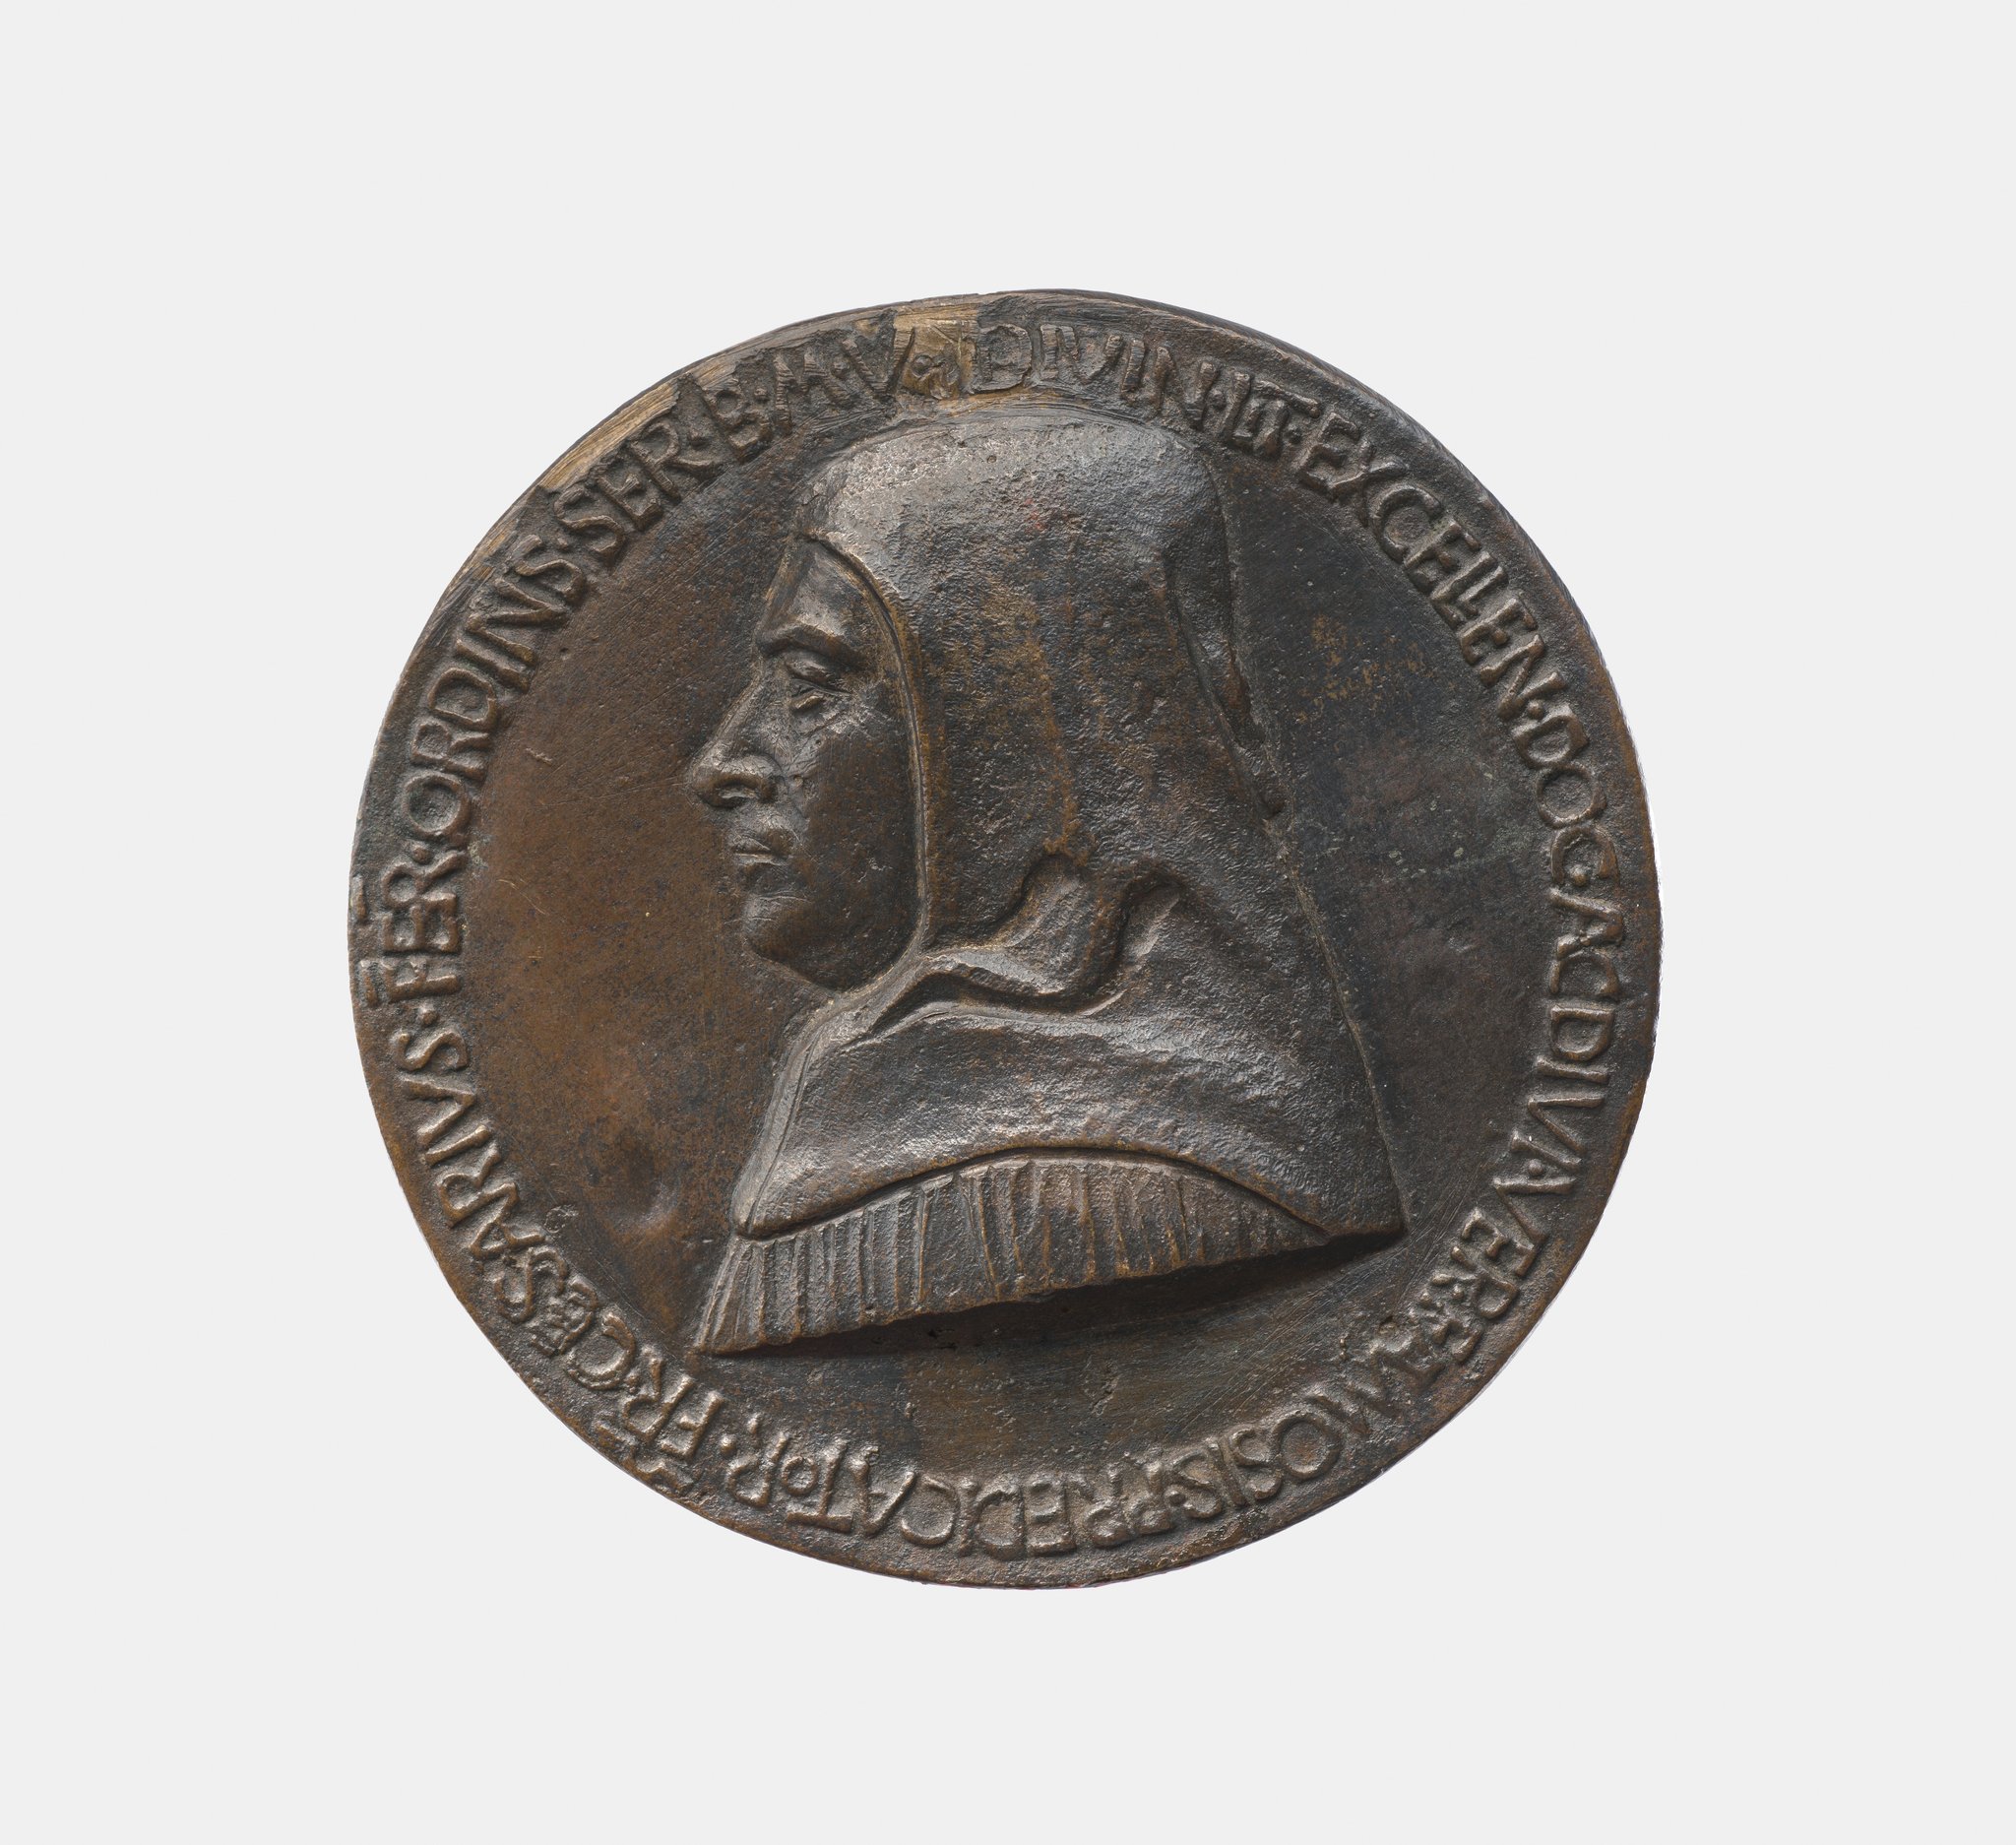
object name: medal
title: Fra Cesario Contughi, of Ferrara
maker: savelli sperandio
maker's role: artist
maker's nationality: italian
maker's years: 1425-1504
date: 1462-1477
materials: bronze